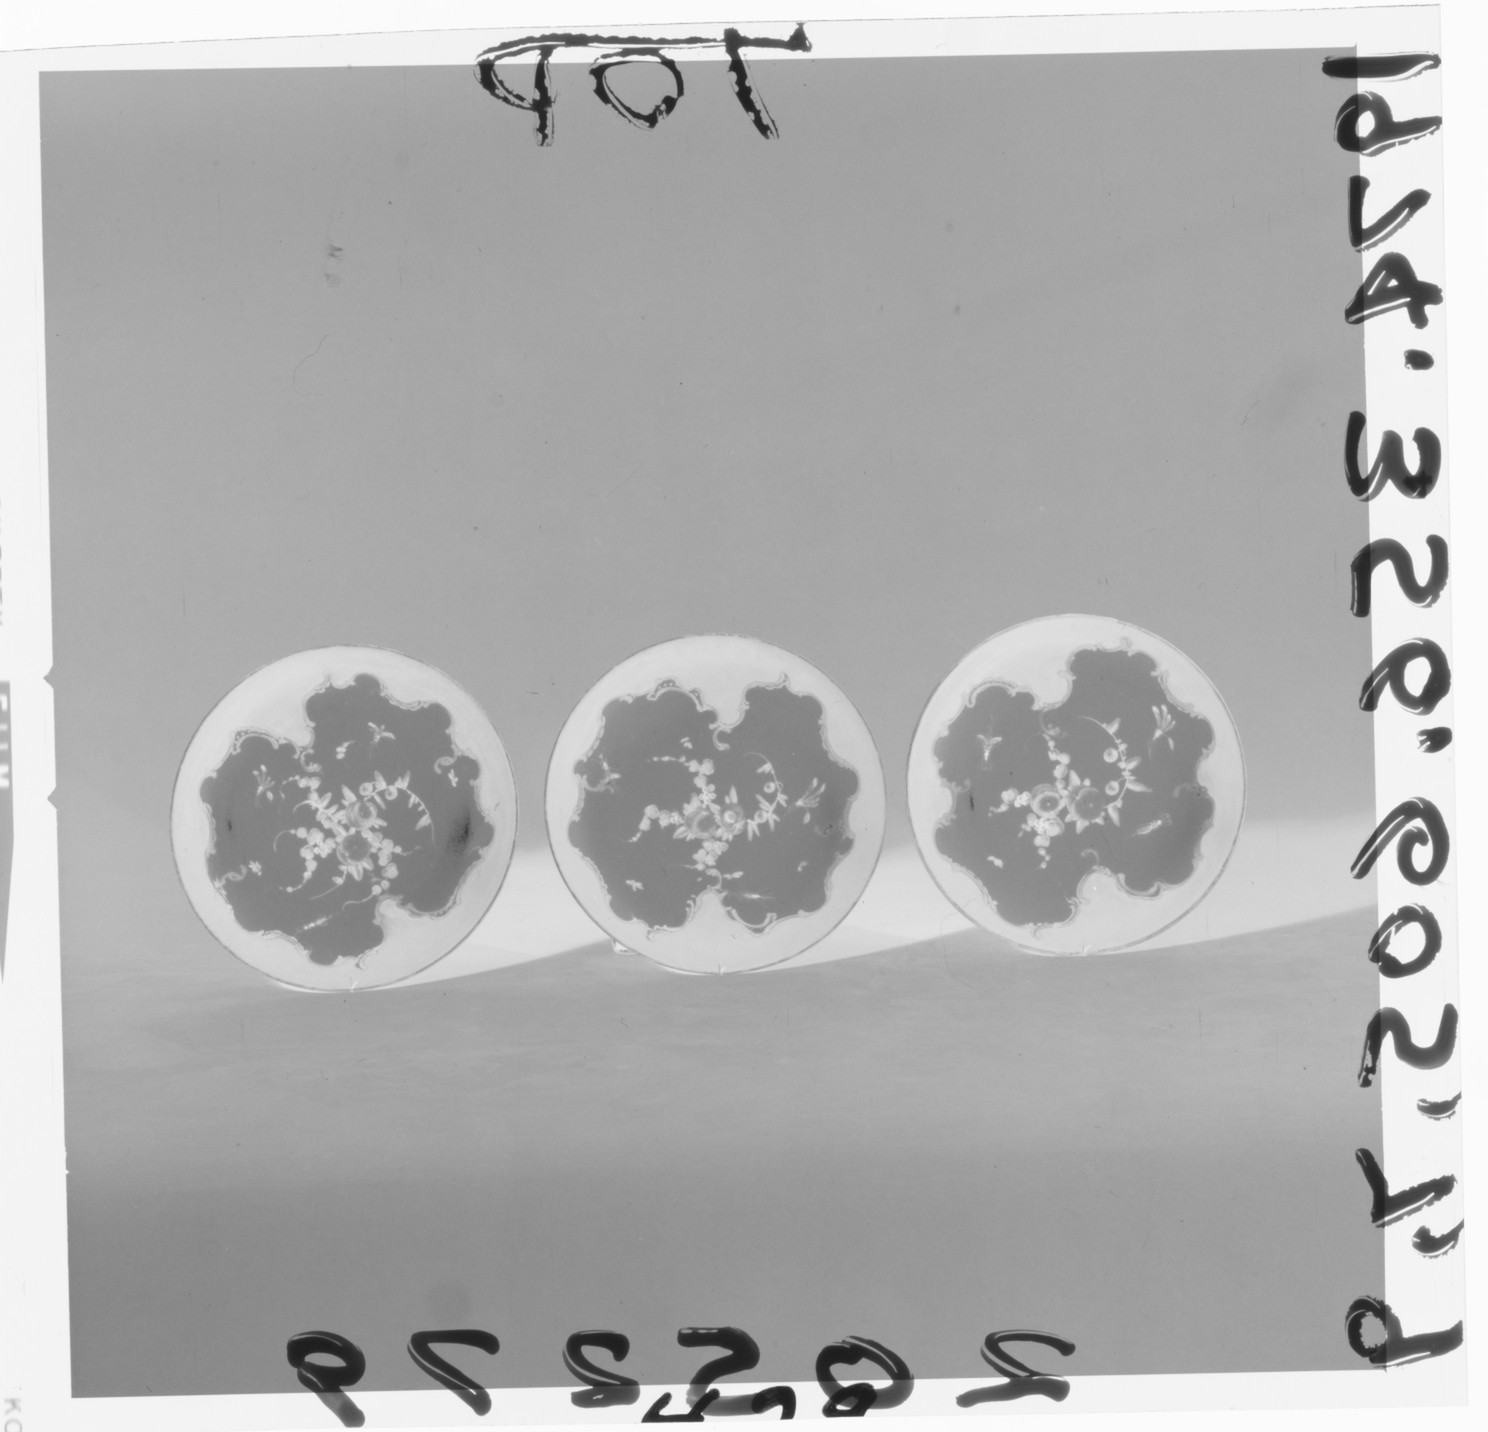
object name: saucer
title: Saucer (part of a service)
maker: worcester factory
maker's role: factory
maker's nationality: british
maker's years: 1751-2008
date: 1770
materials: soft paste porcelain